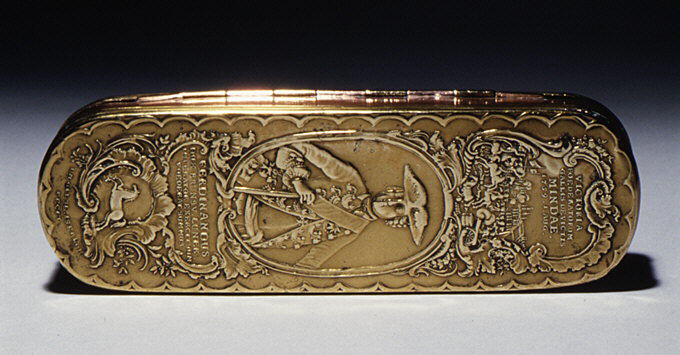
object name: tobacco box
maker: johann heinrich giese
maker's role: maker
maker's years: 1716-1761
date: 1760-1765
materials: brass, copper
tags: men,horses